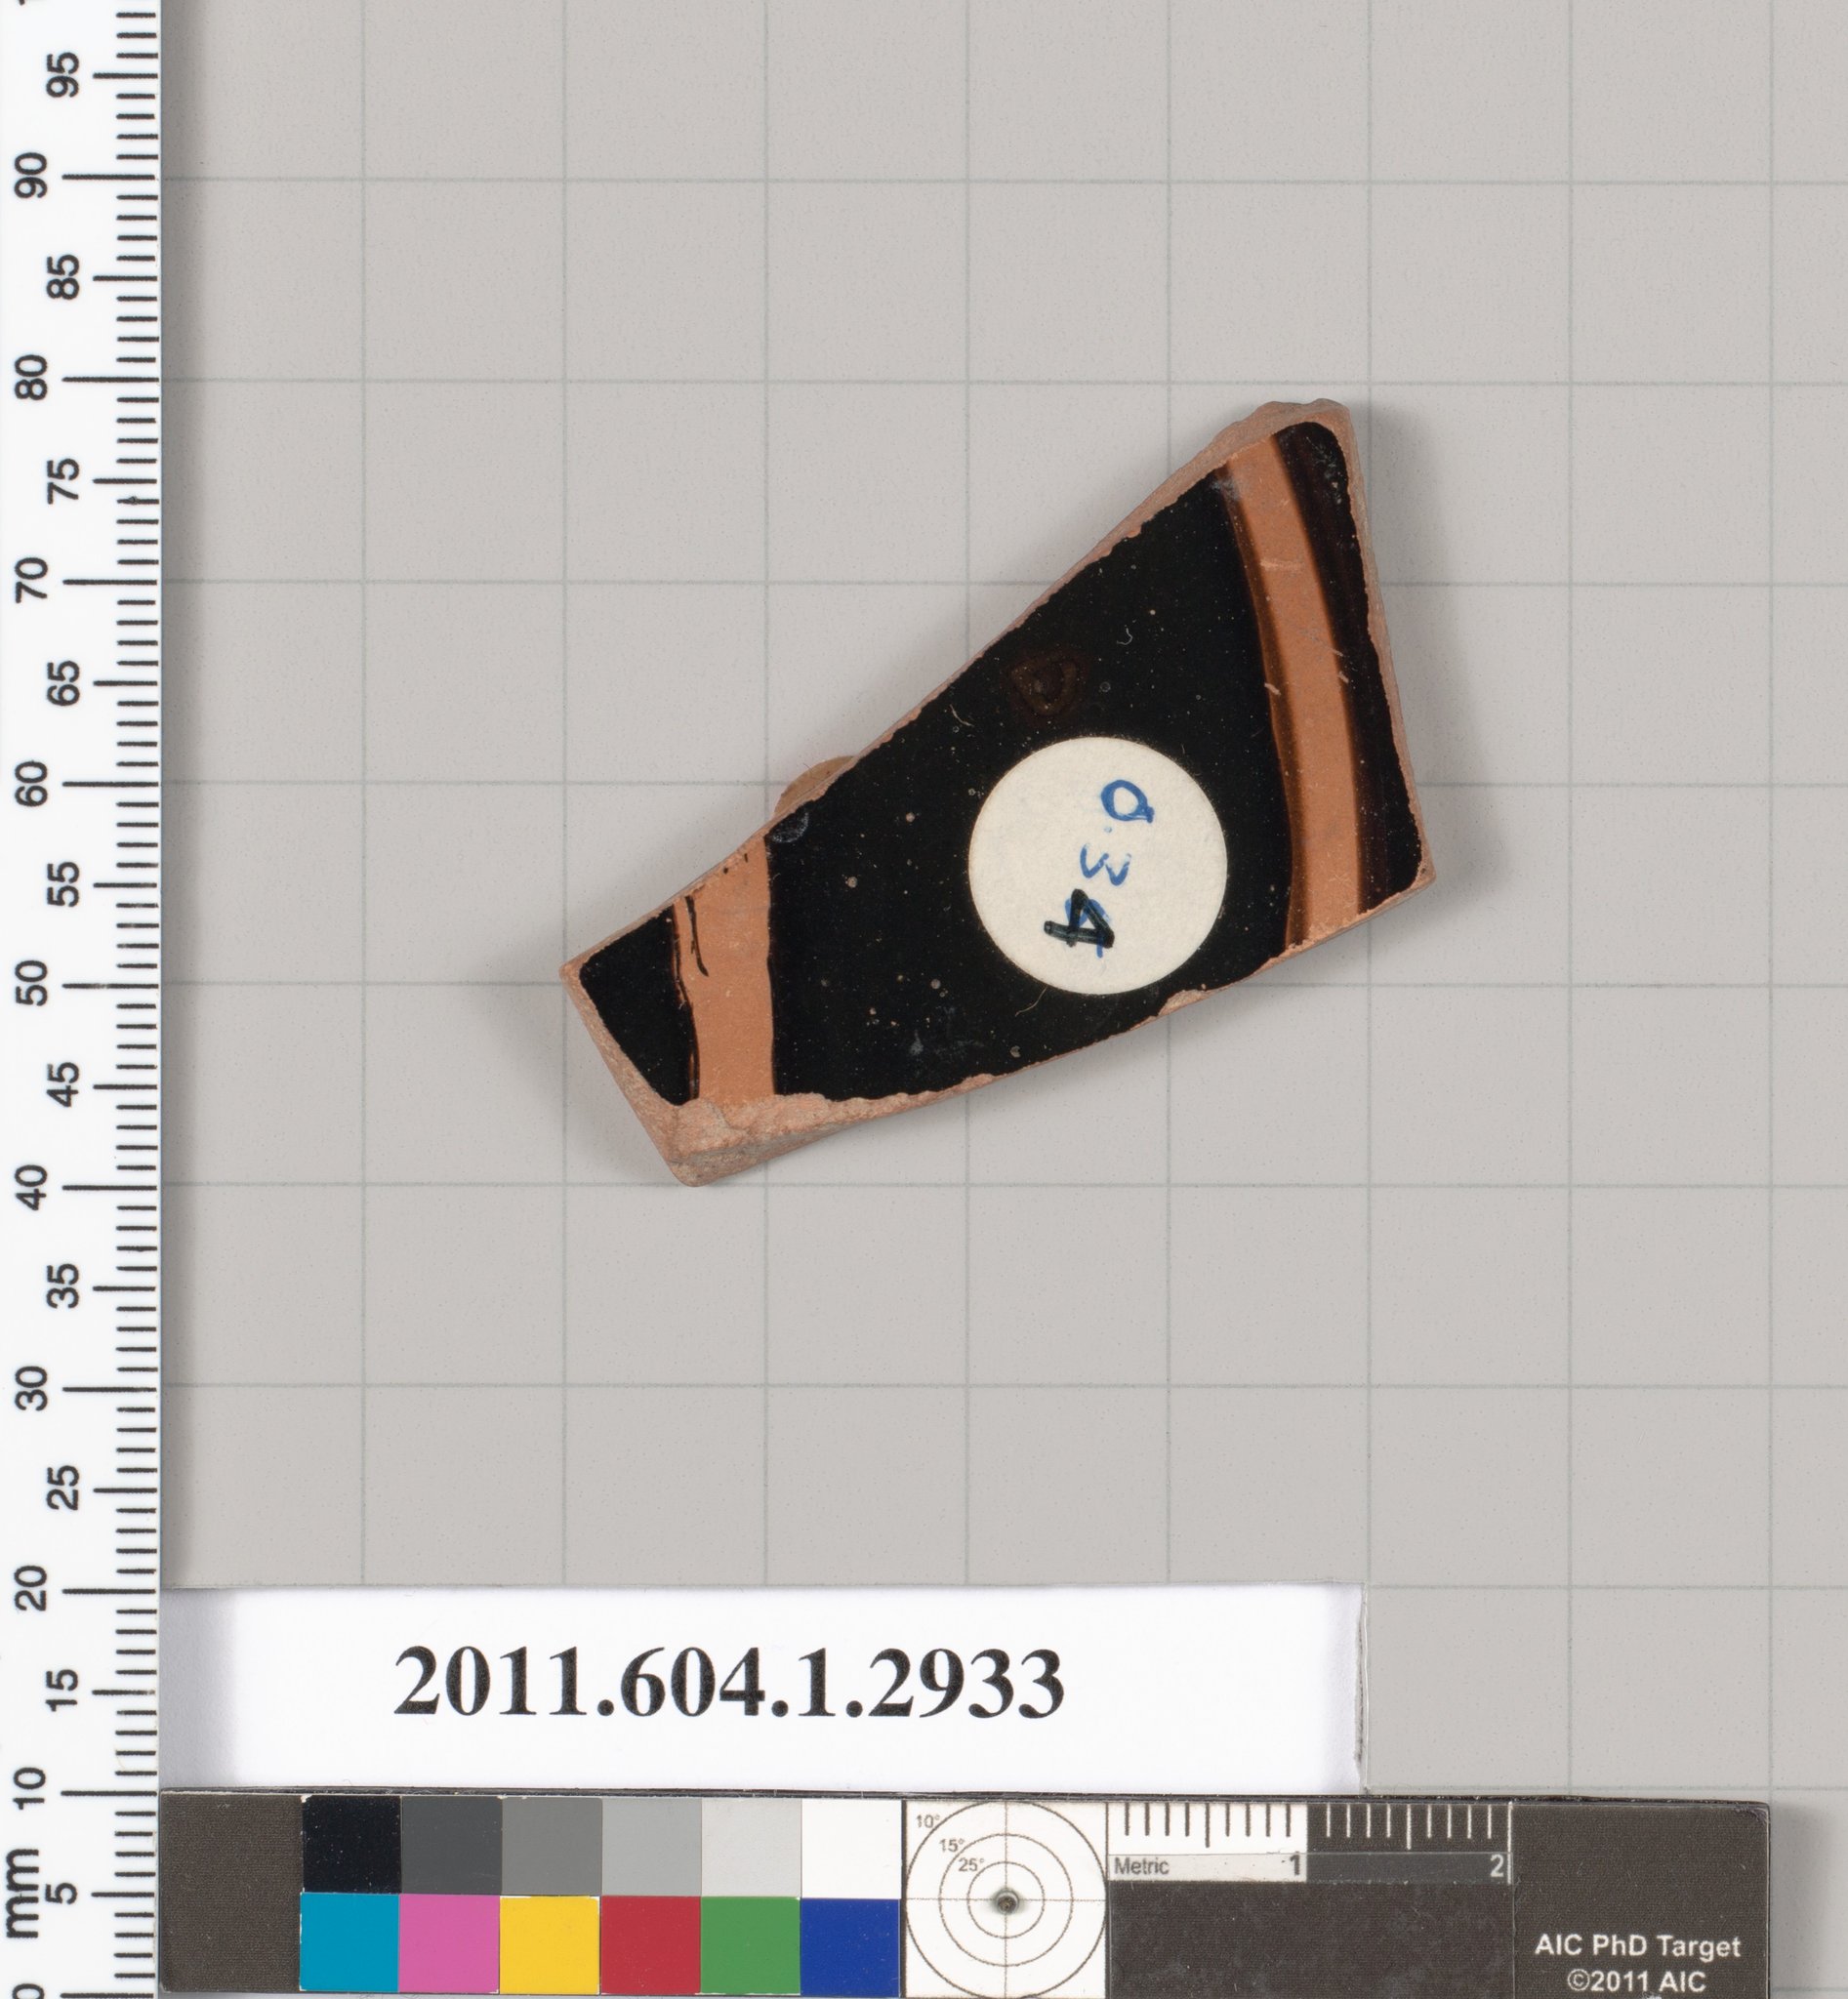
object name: kylix fragment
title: Terracotta fragment of a kylix (drinking cup)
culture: greek, attic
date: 500-476 BCE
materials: terracotta